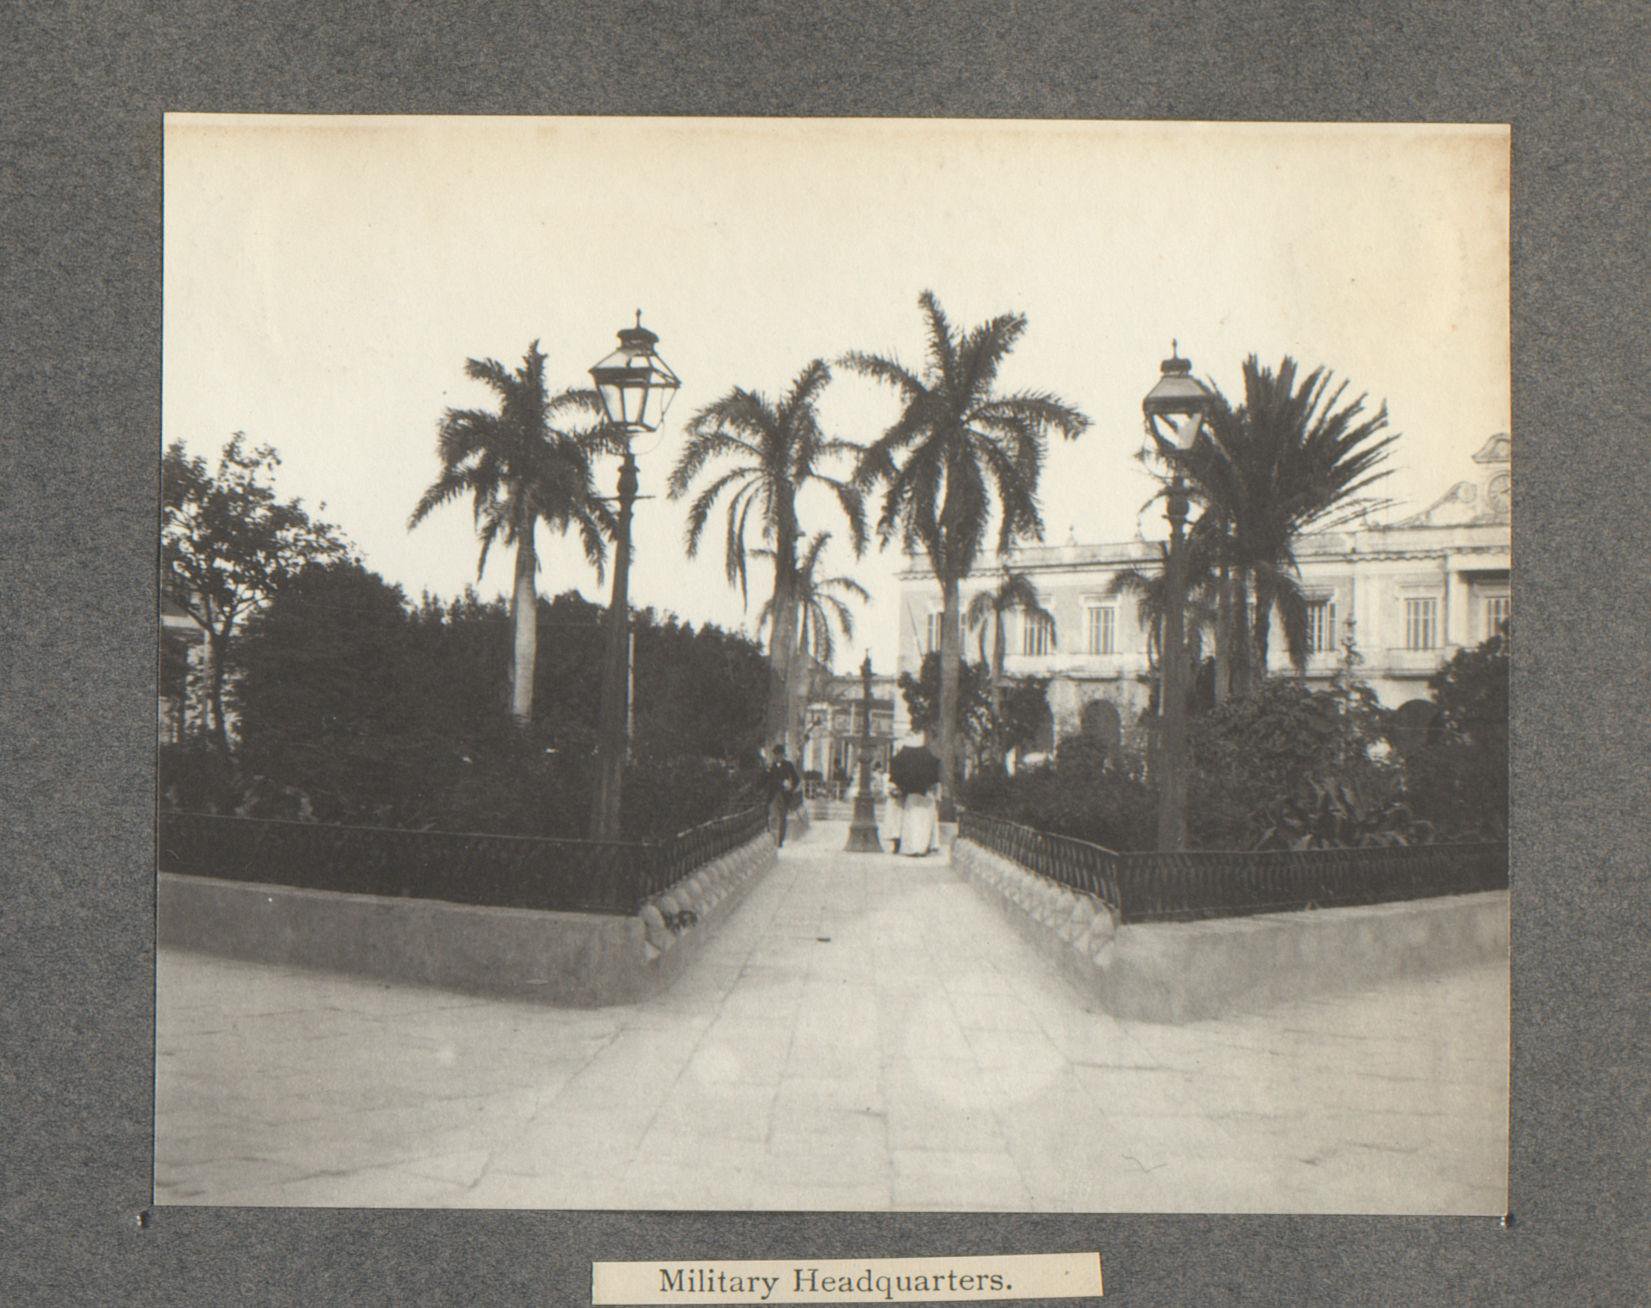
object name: photograph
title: Gezicht op het Governor Palace in Matanzas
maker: Anonymous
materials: paper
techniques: platinum process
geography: matanzas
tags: public gardens, park (+ city(-scape) with figures, staffage), exterior ~ representation of a building